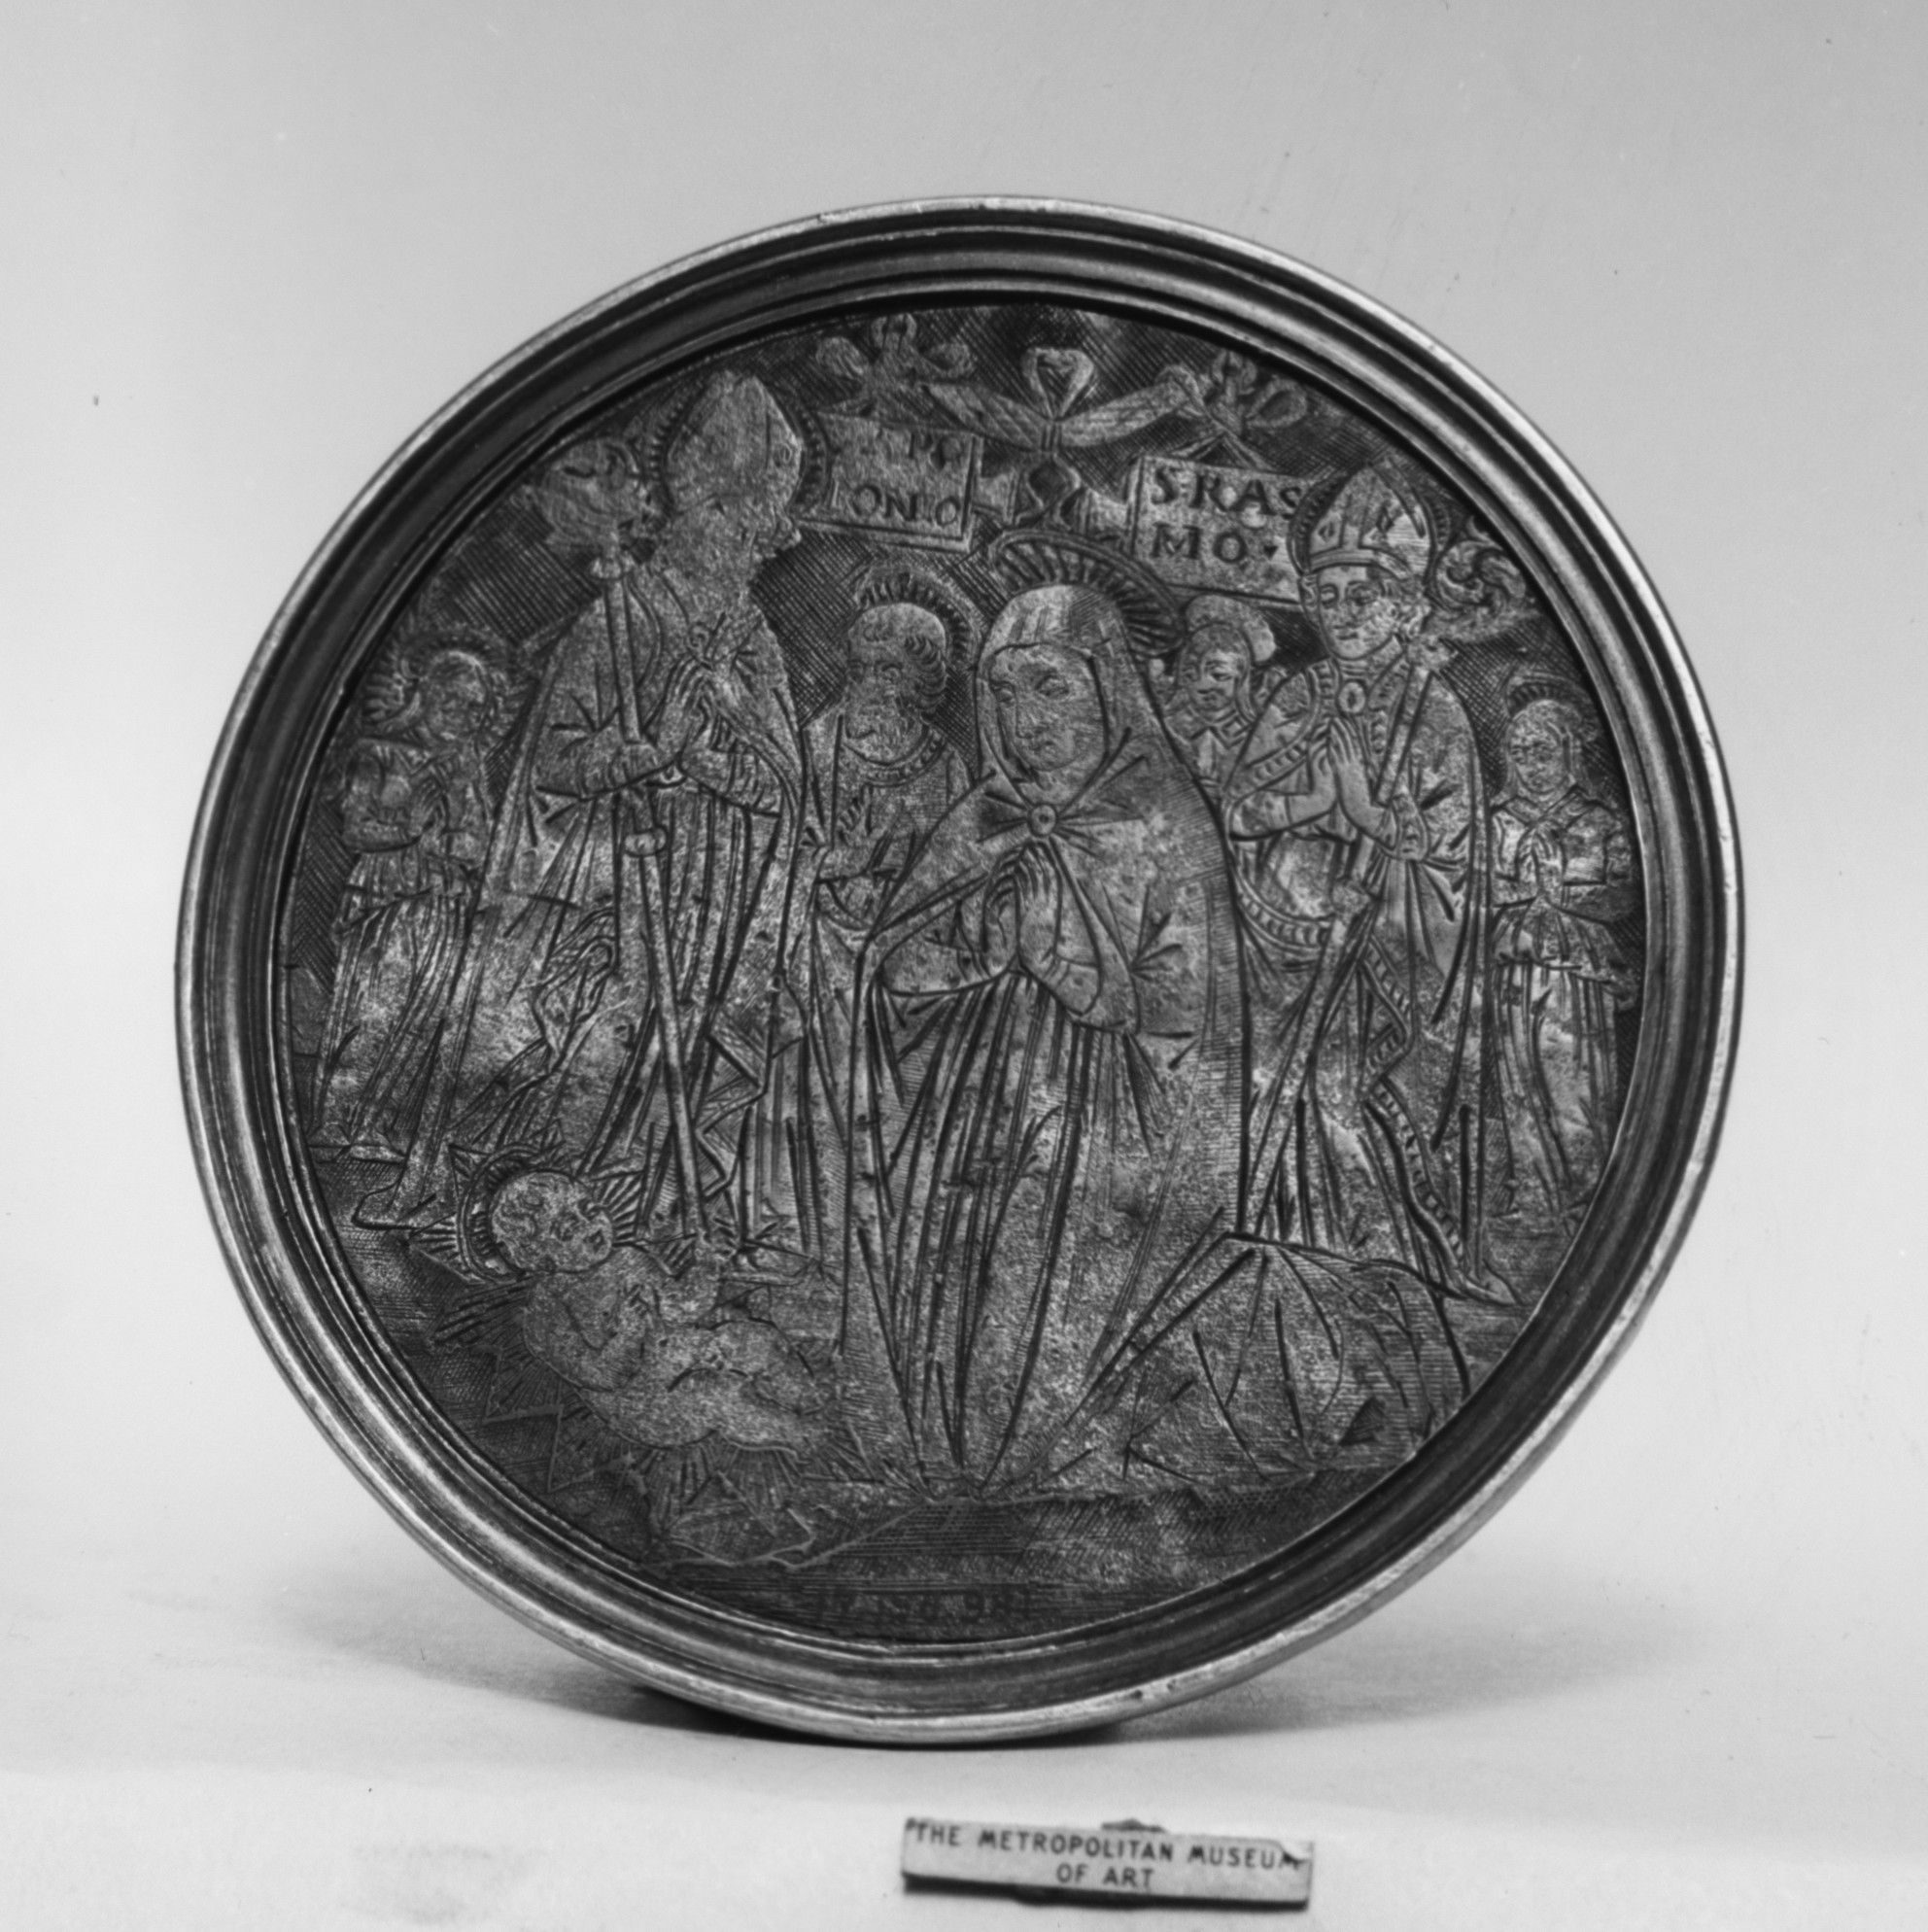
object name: medallion plaque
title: Nativity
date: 1451-1500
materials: niello, silver gilt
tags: men,women,nativity